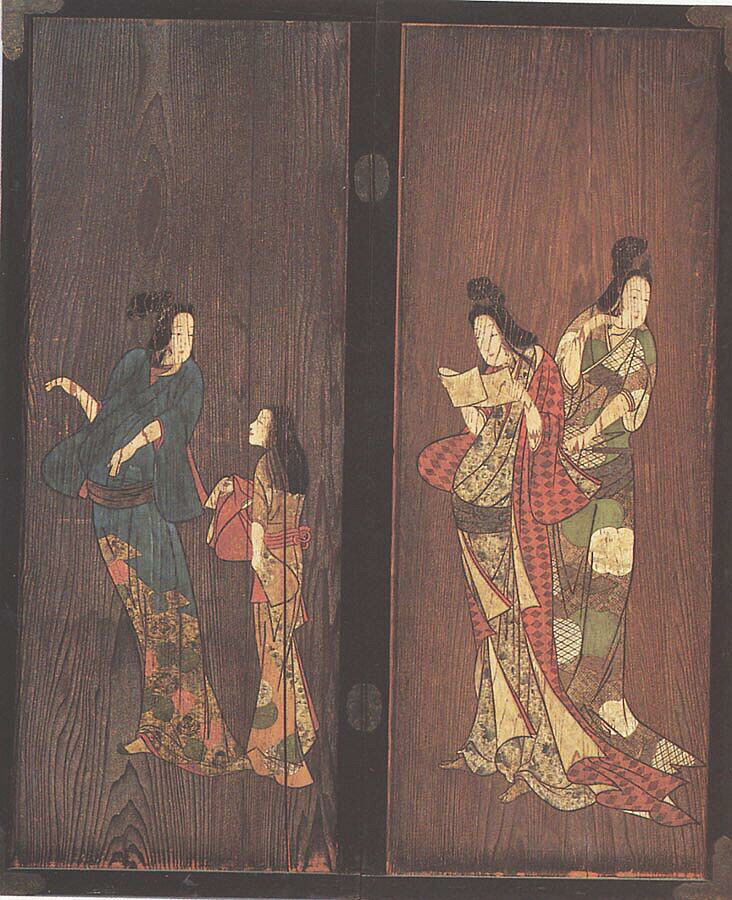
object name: door panel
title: Courtesans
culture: japanese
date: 1630-1640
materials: wood, panel, pigment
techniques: painting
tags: women